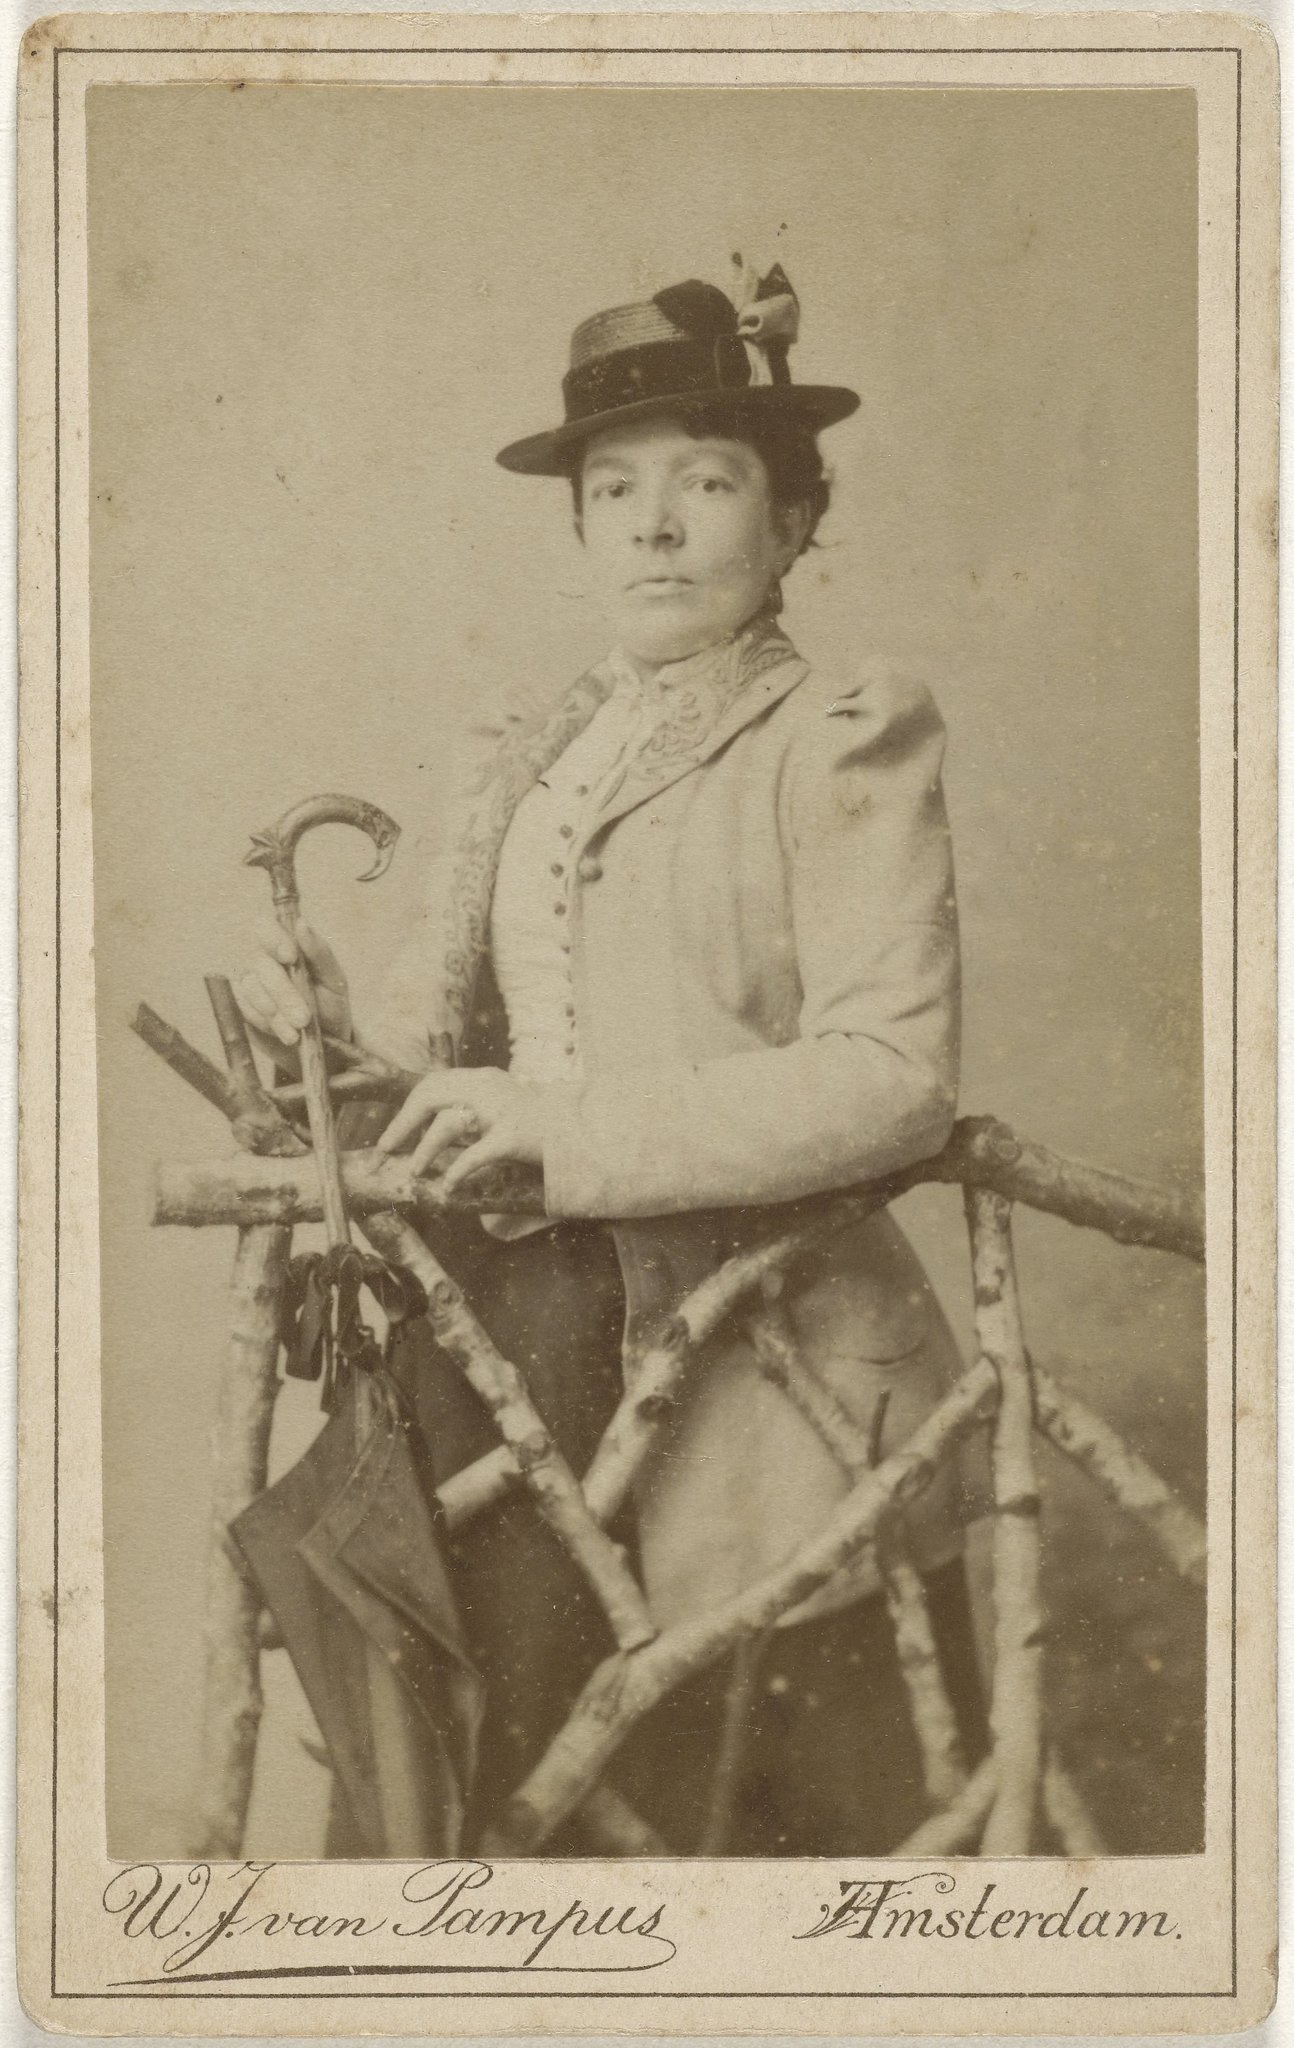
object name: photograph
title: Studioportret van dame met paraplue achter houten hekje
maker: wilhelmus johannes van pampus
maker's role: fotograaf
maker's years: 1860-1920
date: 1908-1915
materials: photographic support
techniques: albumen print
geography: amsterdam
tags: amsterdam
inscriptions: name: ‘Photographisch atelier van W.J. van Pampus Vijzelgracht 41 Amsterdam’